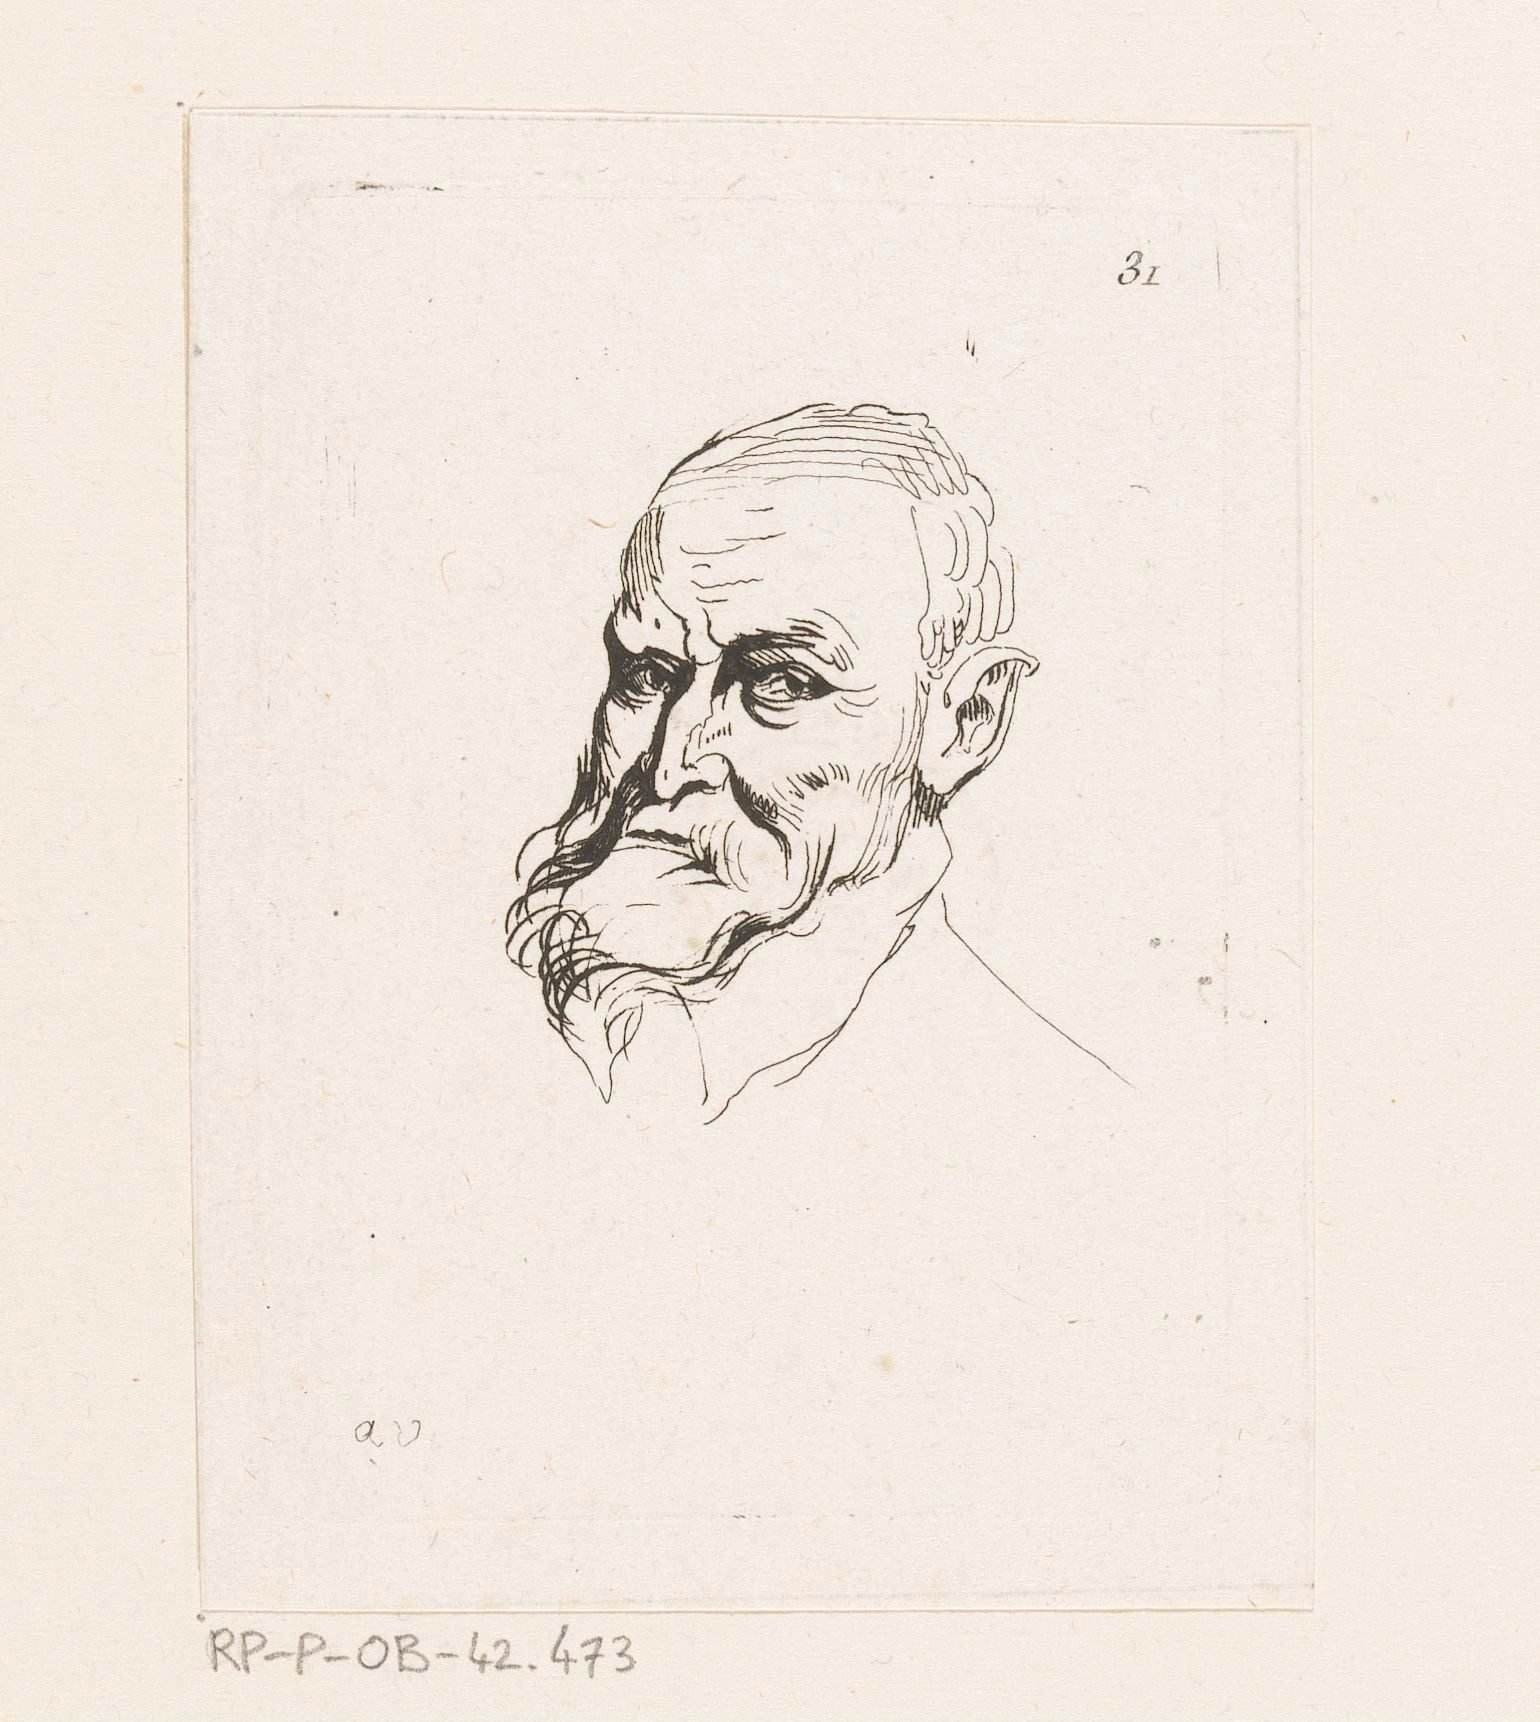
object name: print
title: Recueil de Testes d'Antoine Van Dyck (...)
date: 1735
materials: paper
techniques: etching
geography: france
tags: head (human), adult man, beard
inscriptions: collector's mark: Lugt 240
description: Prent uit een serie van 31 prenten naar getekende hoofden door Van Dyck, plus een titelprent naar Bouchardon, getiteld: "Recueil de Testes d'Antoine Van Dyck tirées du Cabinet de M. Crozat et gravées par M. le C. de C.".